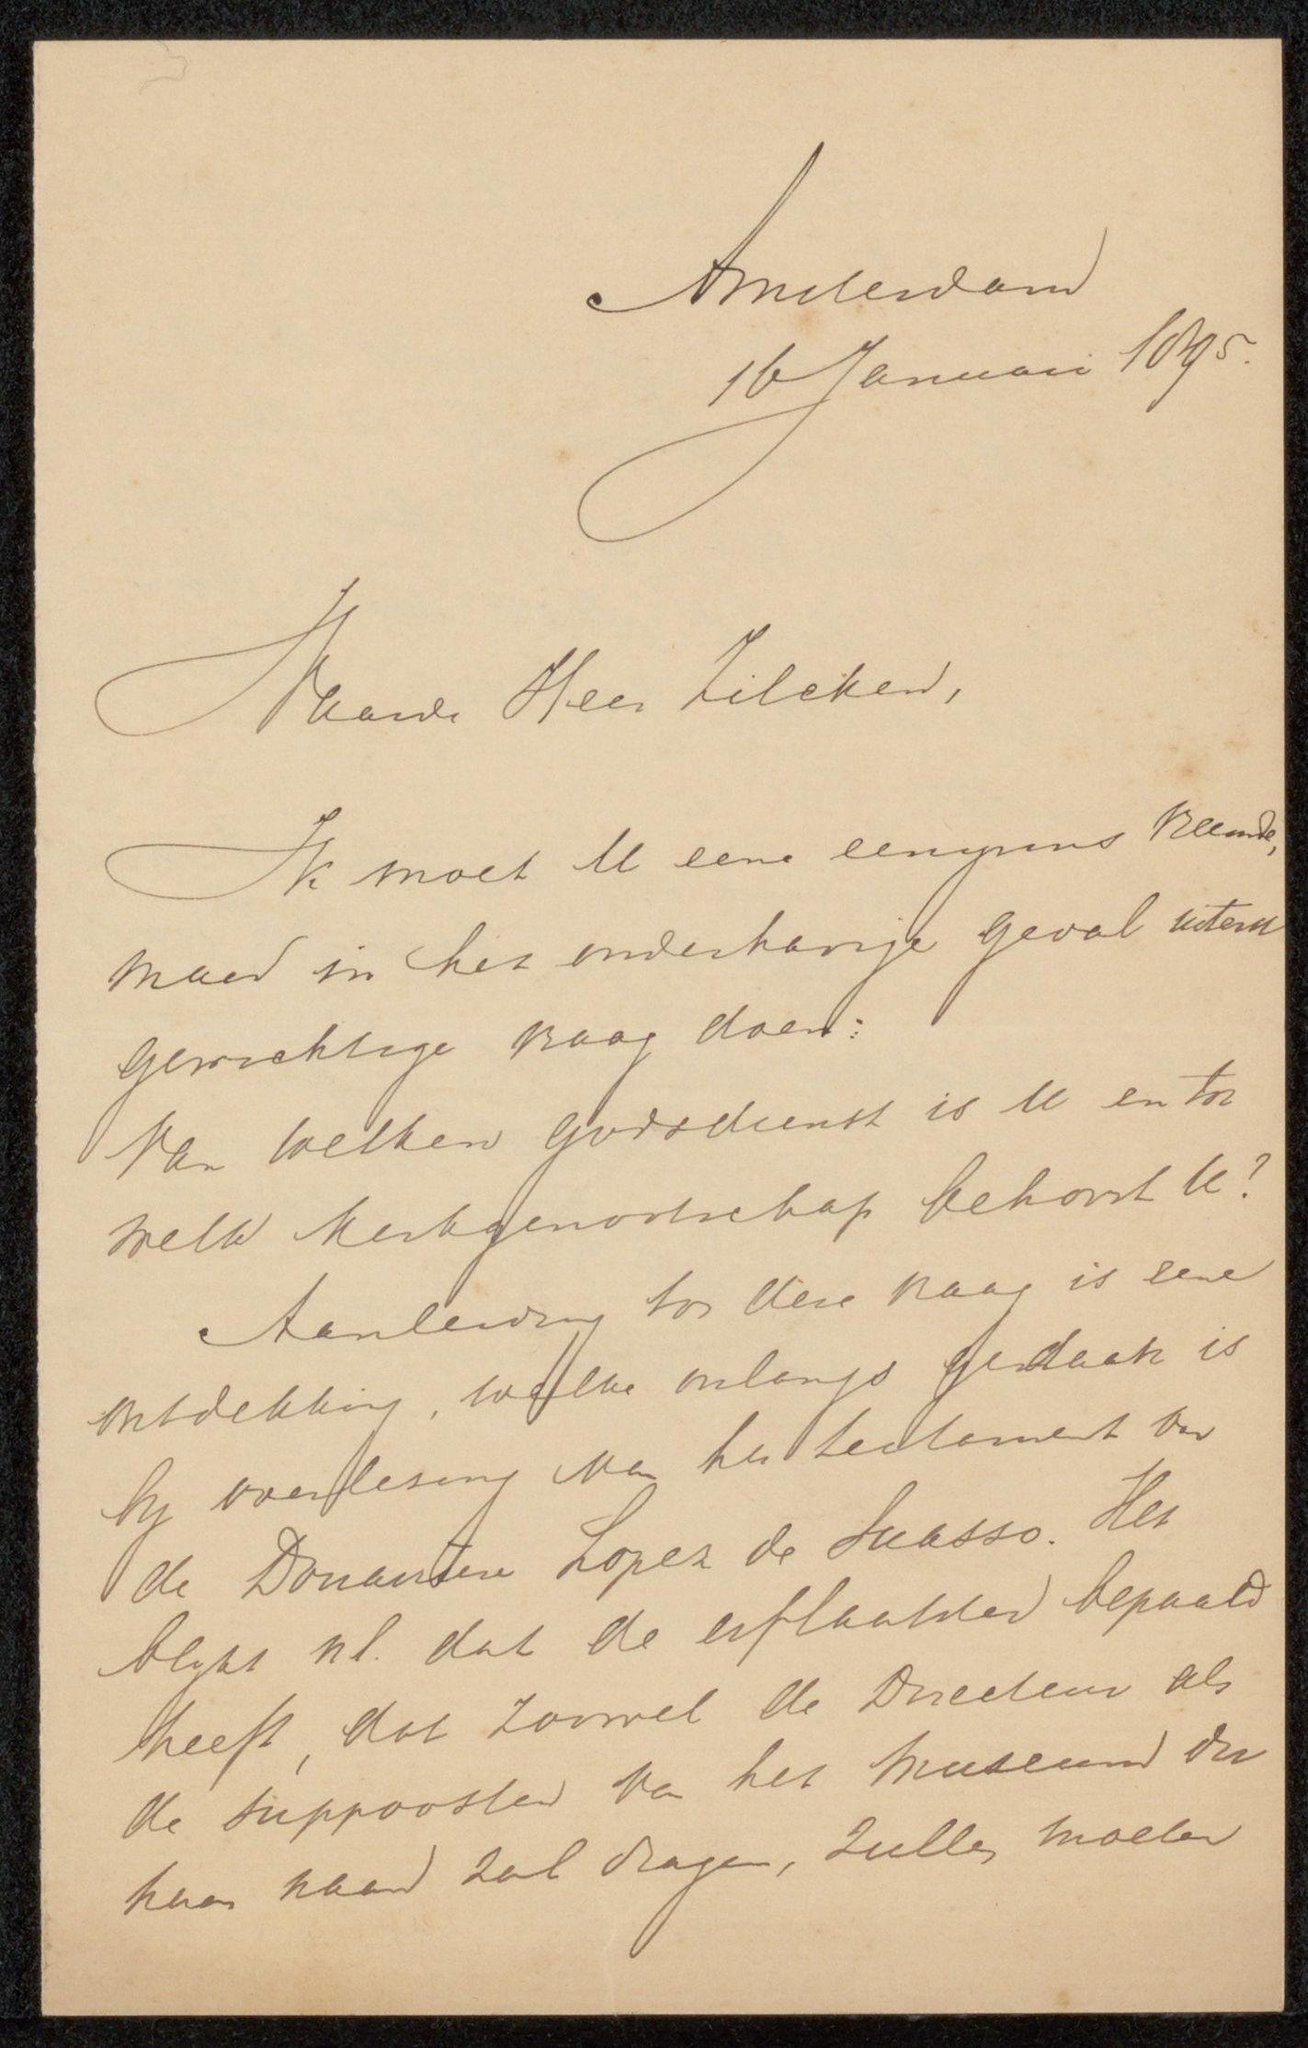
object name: letter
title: Brief aan Philip Zilcken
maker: jacob nicolaas van hall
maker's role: politician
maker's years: 1840-1918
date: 1895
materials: ink, paper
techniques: pen, writing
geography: amsterdam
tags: painter, draughtsman, philip zilcken, permanent exhibition, museum, christian religion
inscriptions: collector's mark: ‘RPK’